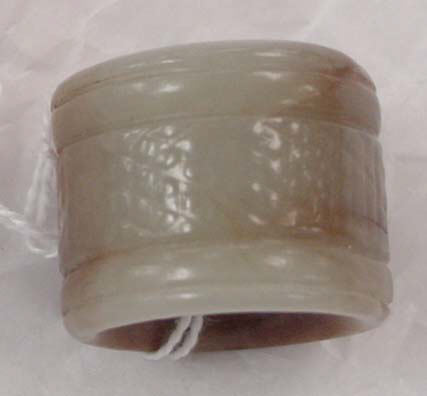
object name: ring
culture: chinese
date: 1801-1900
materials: jade